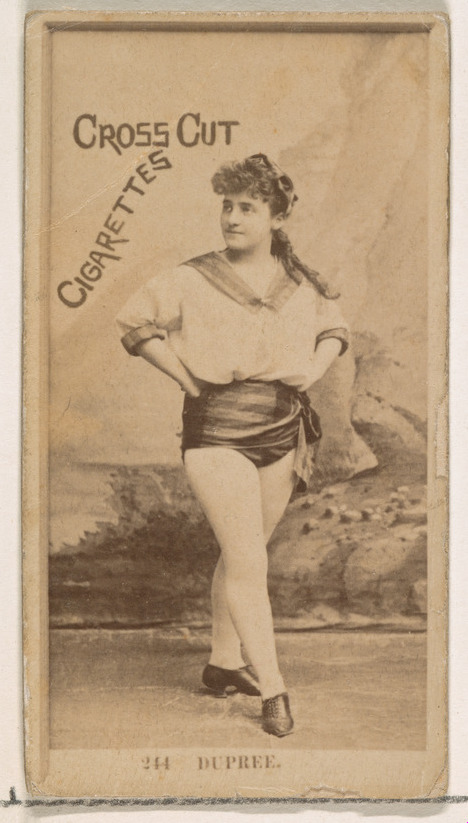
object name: print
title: Card Number 244, Dupree, from the Actors and Actresses series (N145-2) issued by Duke Sons & Co. to promote Cross Cut Cigarettes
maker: w. duke, sons & co.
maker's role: publisher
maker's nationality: american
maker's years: 1870-1920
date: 1880-1889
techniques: albumen silver print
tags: portraits,women,actresses